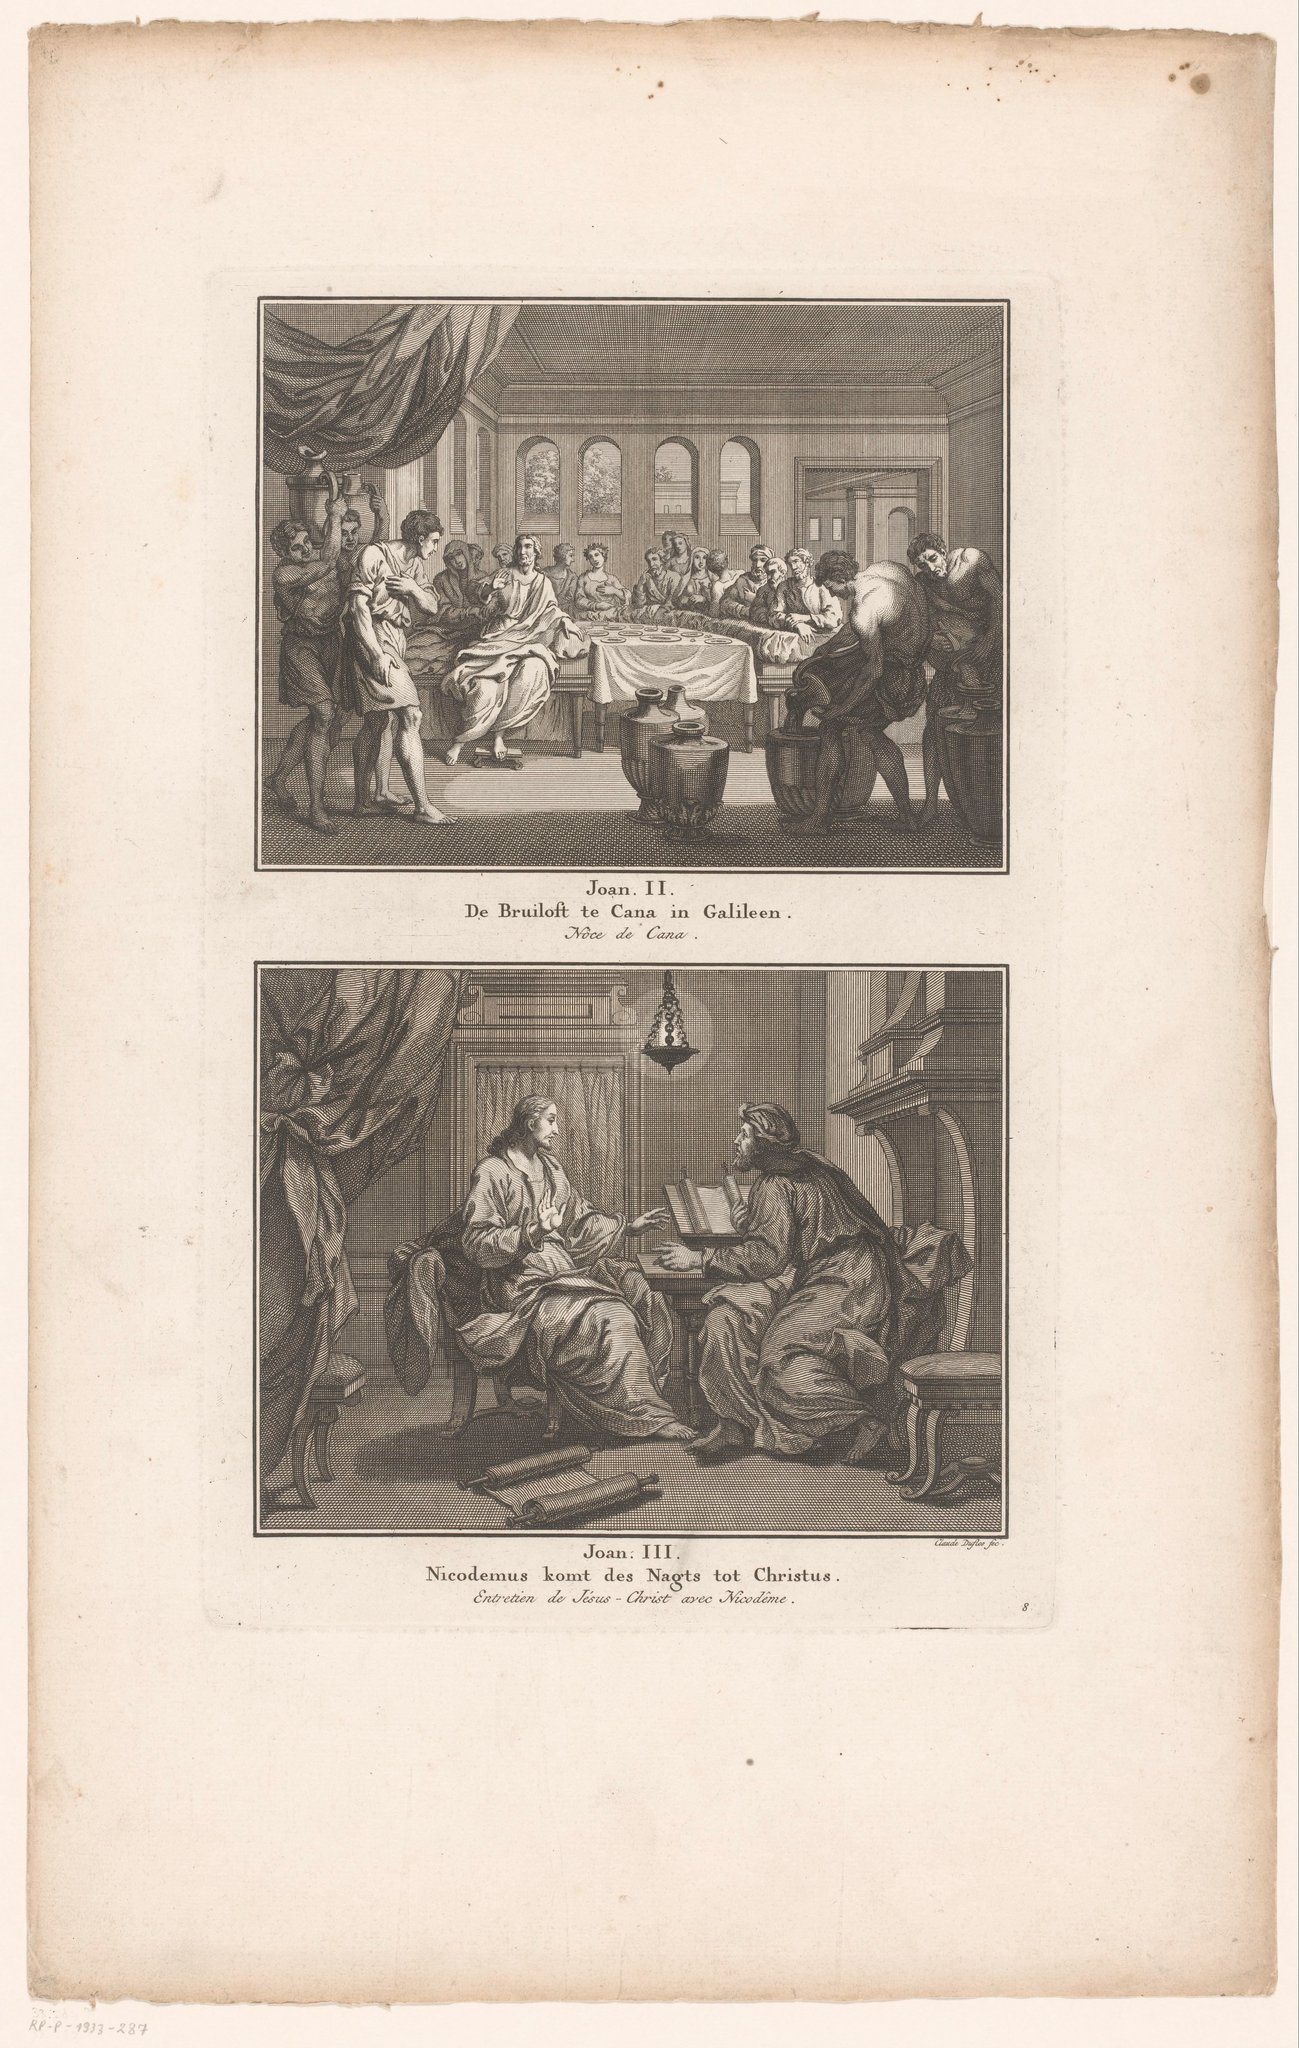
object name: print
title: De Bruiloft te Cana in Galileen / Nicodemus komt des Nagts tot Christus.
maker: claude augustin duflos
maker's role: print maker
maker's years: 1700-1786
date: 1710-1786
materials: paper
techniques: engraving, etching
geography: france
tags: christ talking with nicodemus at night (john 3:1-21), the marriage-feast at cana (john 2:1-11)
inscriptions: collector's mark: Lugt 2233, collector's mark: Lugt 3937